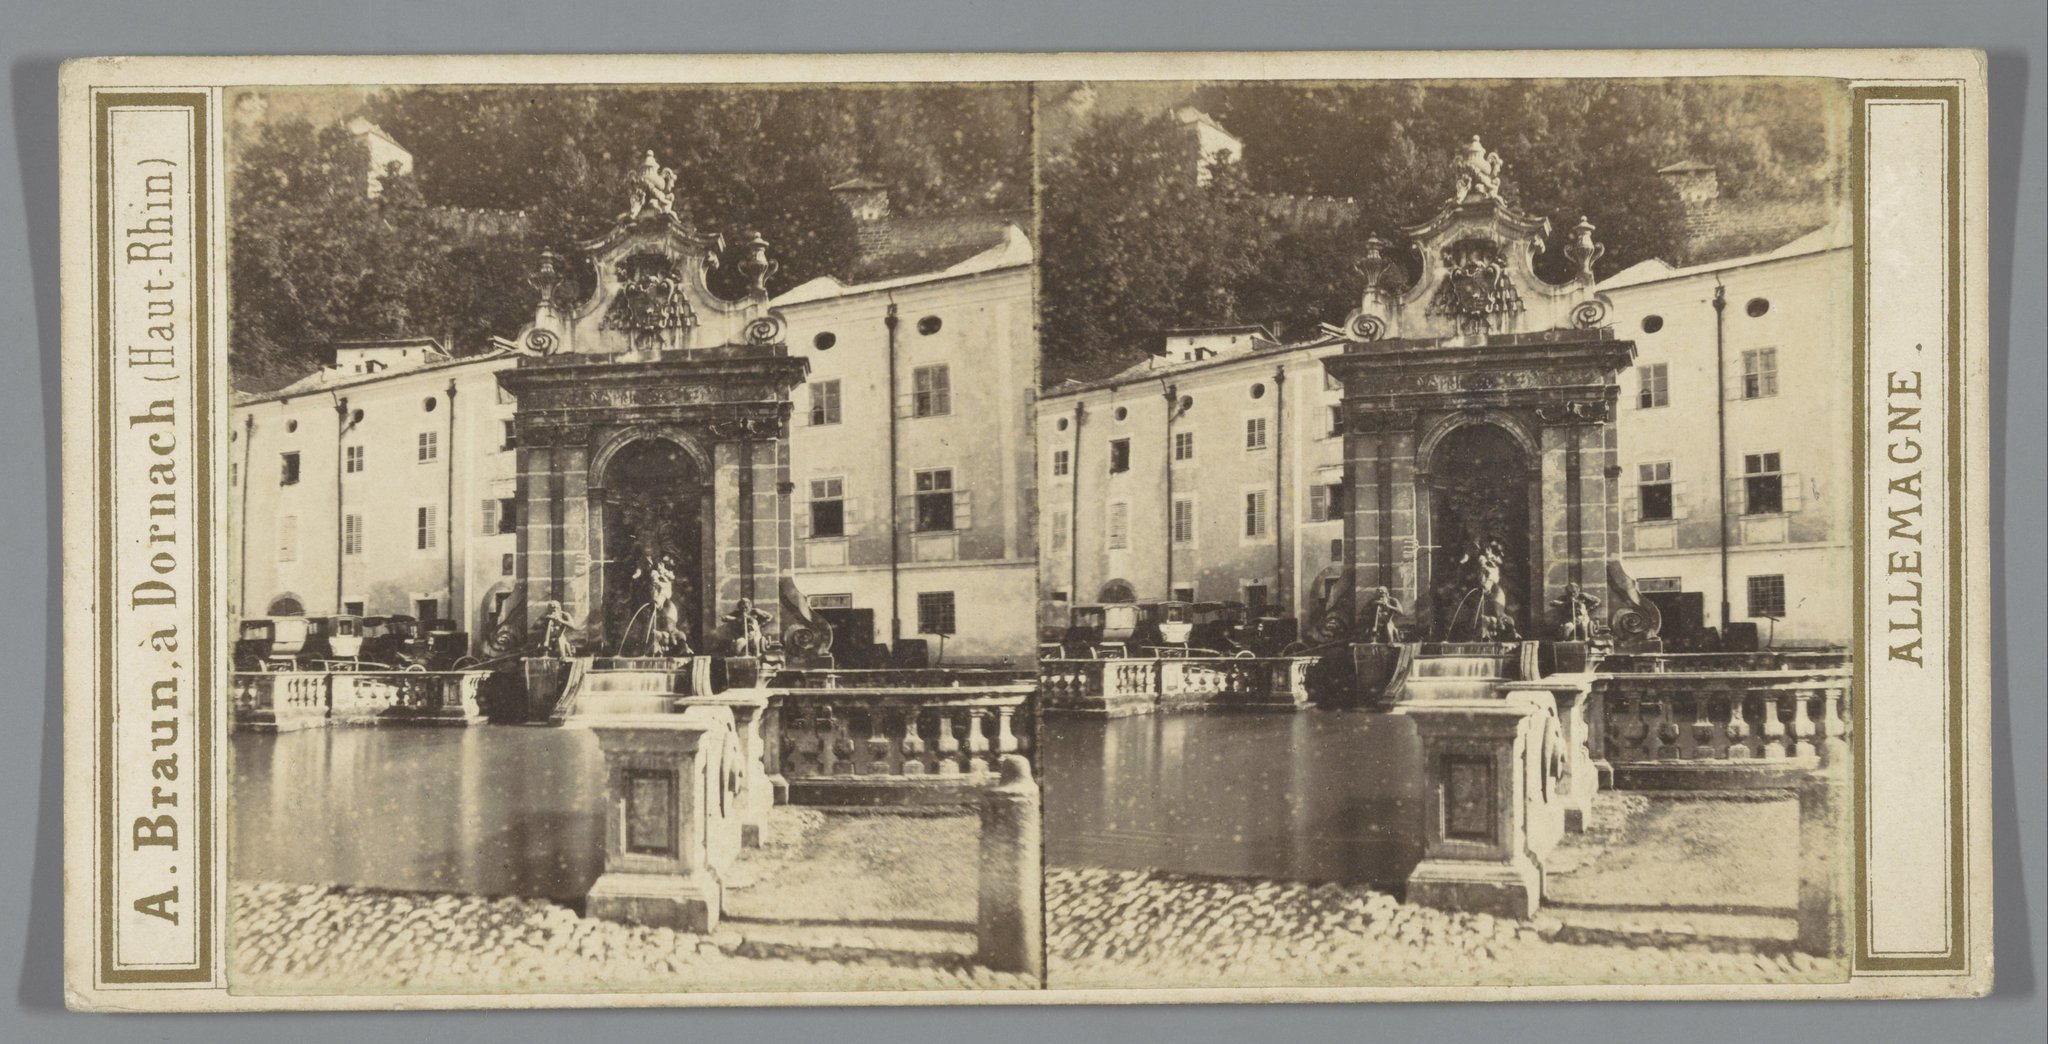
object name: stereograph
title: Salzburg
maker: Anonymous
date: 1860-1866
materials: cardboard, paper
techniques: albumen print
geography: salzburg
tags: square, place, circus, etc.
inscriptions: number: ‘No 1415’